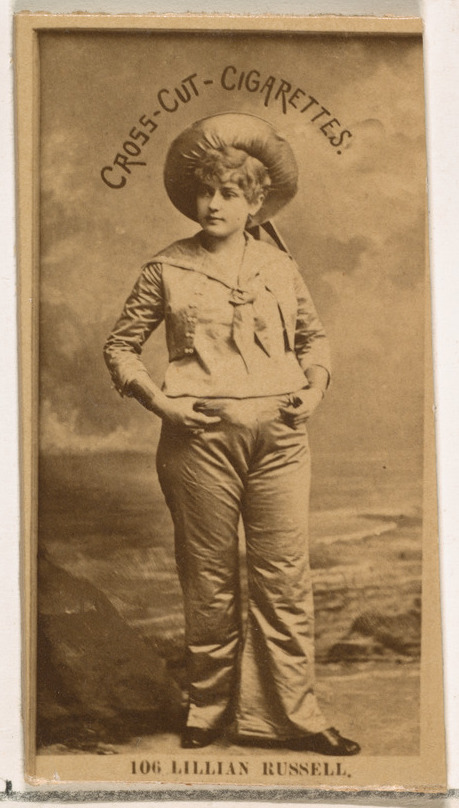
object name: print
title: Card Number 106, Lillian Russell, from the Actors and Actresses series (N145-2) issued by Duke Sons & Co. to promote Cross Cut Cigarettes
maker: w. duke, sons & co.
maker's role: publisher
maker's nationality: american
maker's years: 1870-1920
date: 1880-1889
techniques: albumen silver print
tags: portraits,women,actresses